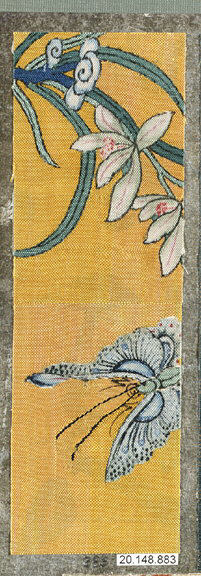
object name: piece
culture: chinese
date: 1601-1700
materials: silk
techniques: compound weave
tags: butterflies,leaves